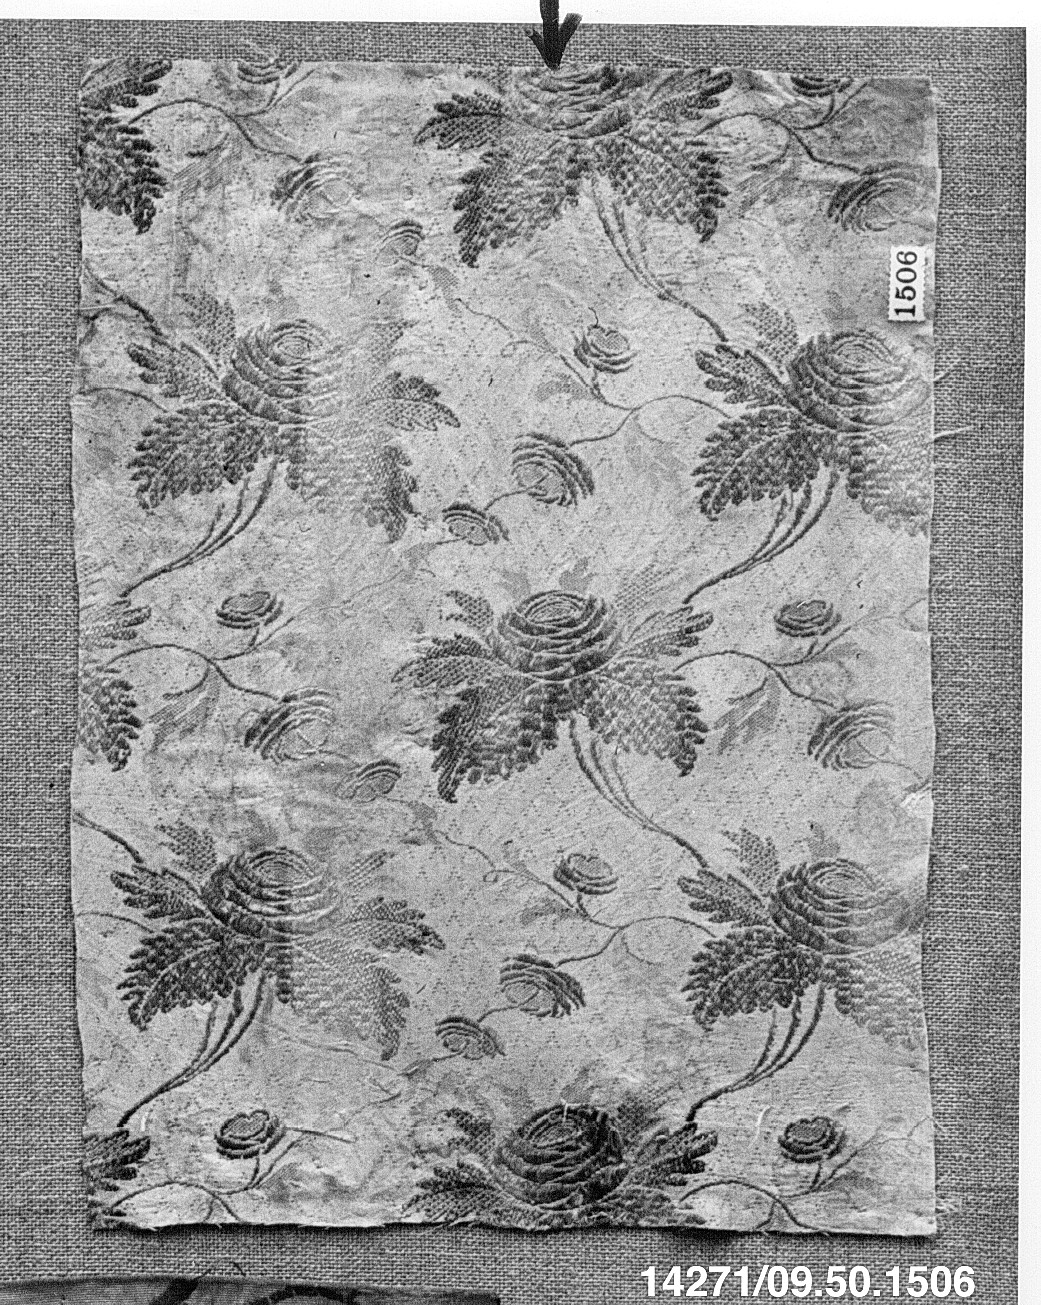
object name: piece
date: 1750-1760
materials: silk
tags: roses,leaves